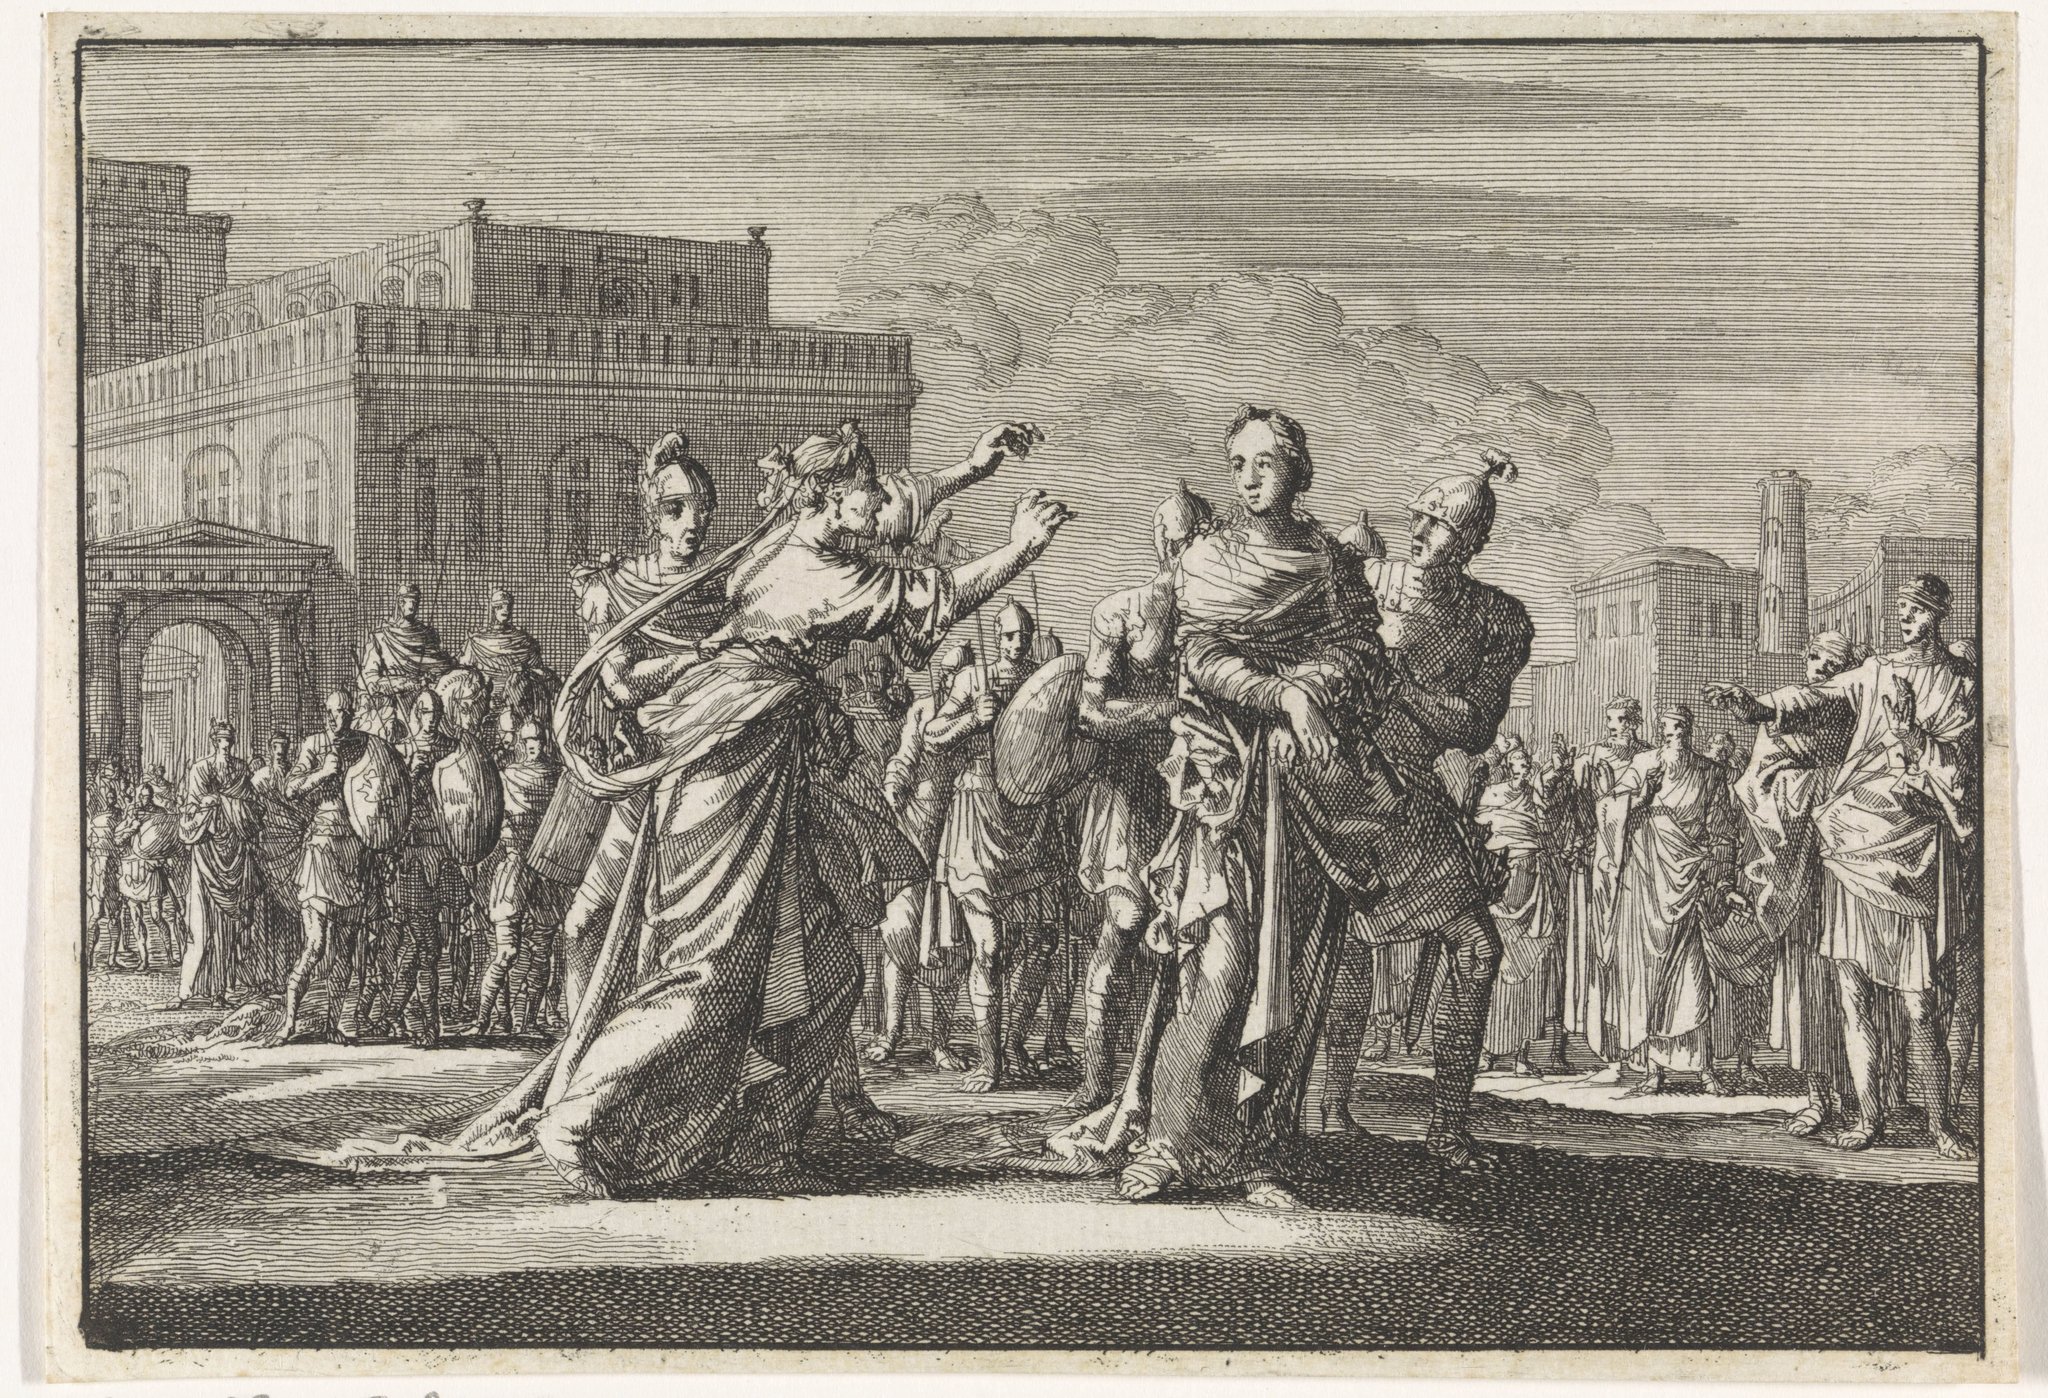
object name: print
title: Marianne wordt weggevoerd om gedood te worden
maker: jan luyken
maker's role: draughtsman, print maker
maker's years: 1649-1712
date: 1704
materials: paper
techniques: etching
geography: amsterdam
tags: last hours before execution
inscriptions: collector's mark: Lugt 2228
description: Prent ook gebruikt als boekillustratie in: Josephus, Flavius. Alle de Werken, 2 delen. Amsterdam: Pieter Mortier, 1704, dl. 2, p. 21.